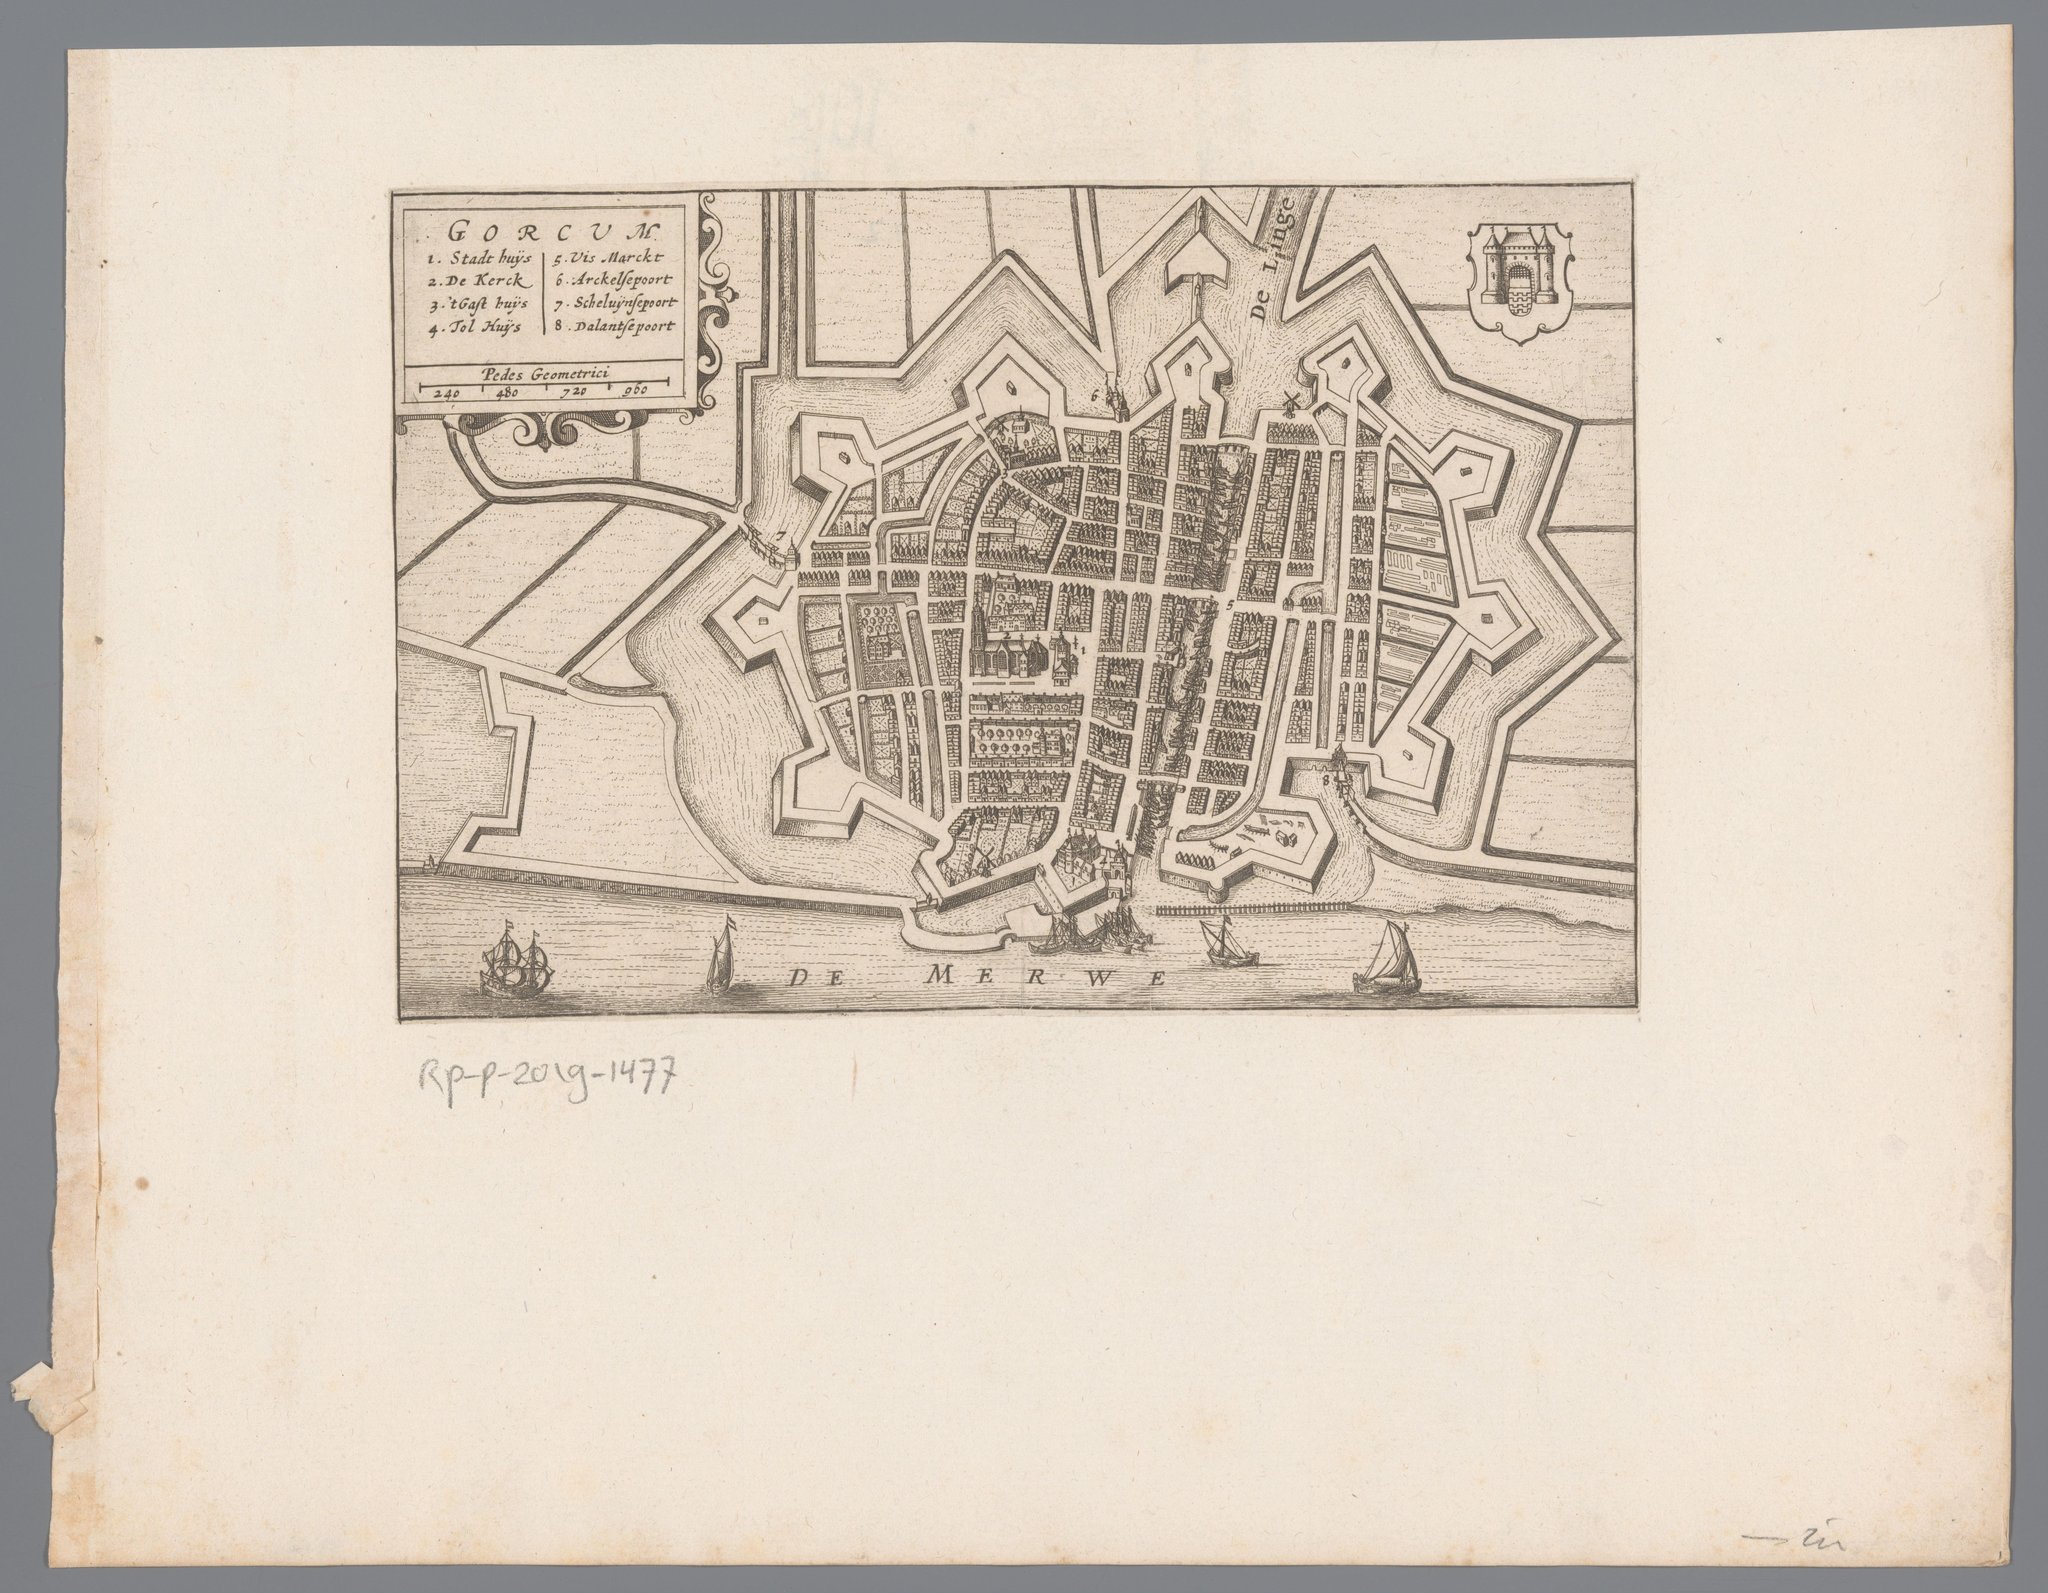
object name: book illustration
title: Plattegrond van Gorinchem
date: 1632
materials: paper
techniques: etching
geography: amsterdam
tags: fortified city, maps of cities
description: Prent uit: Boxhorn, Marcus Zuerius. Theatrum sive Hollandiae comitatus et urbium nova descriptio (...). Amsterdam: Henricus Hondius, 1632, p. 288.